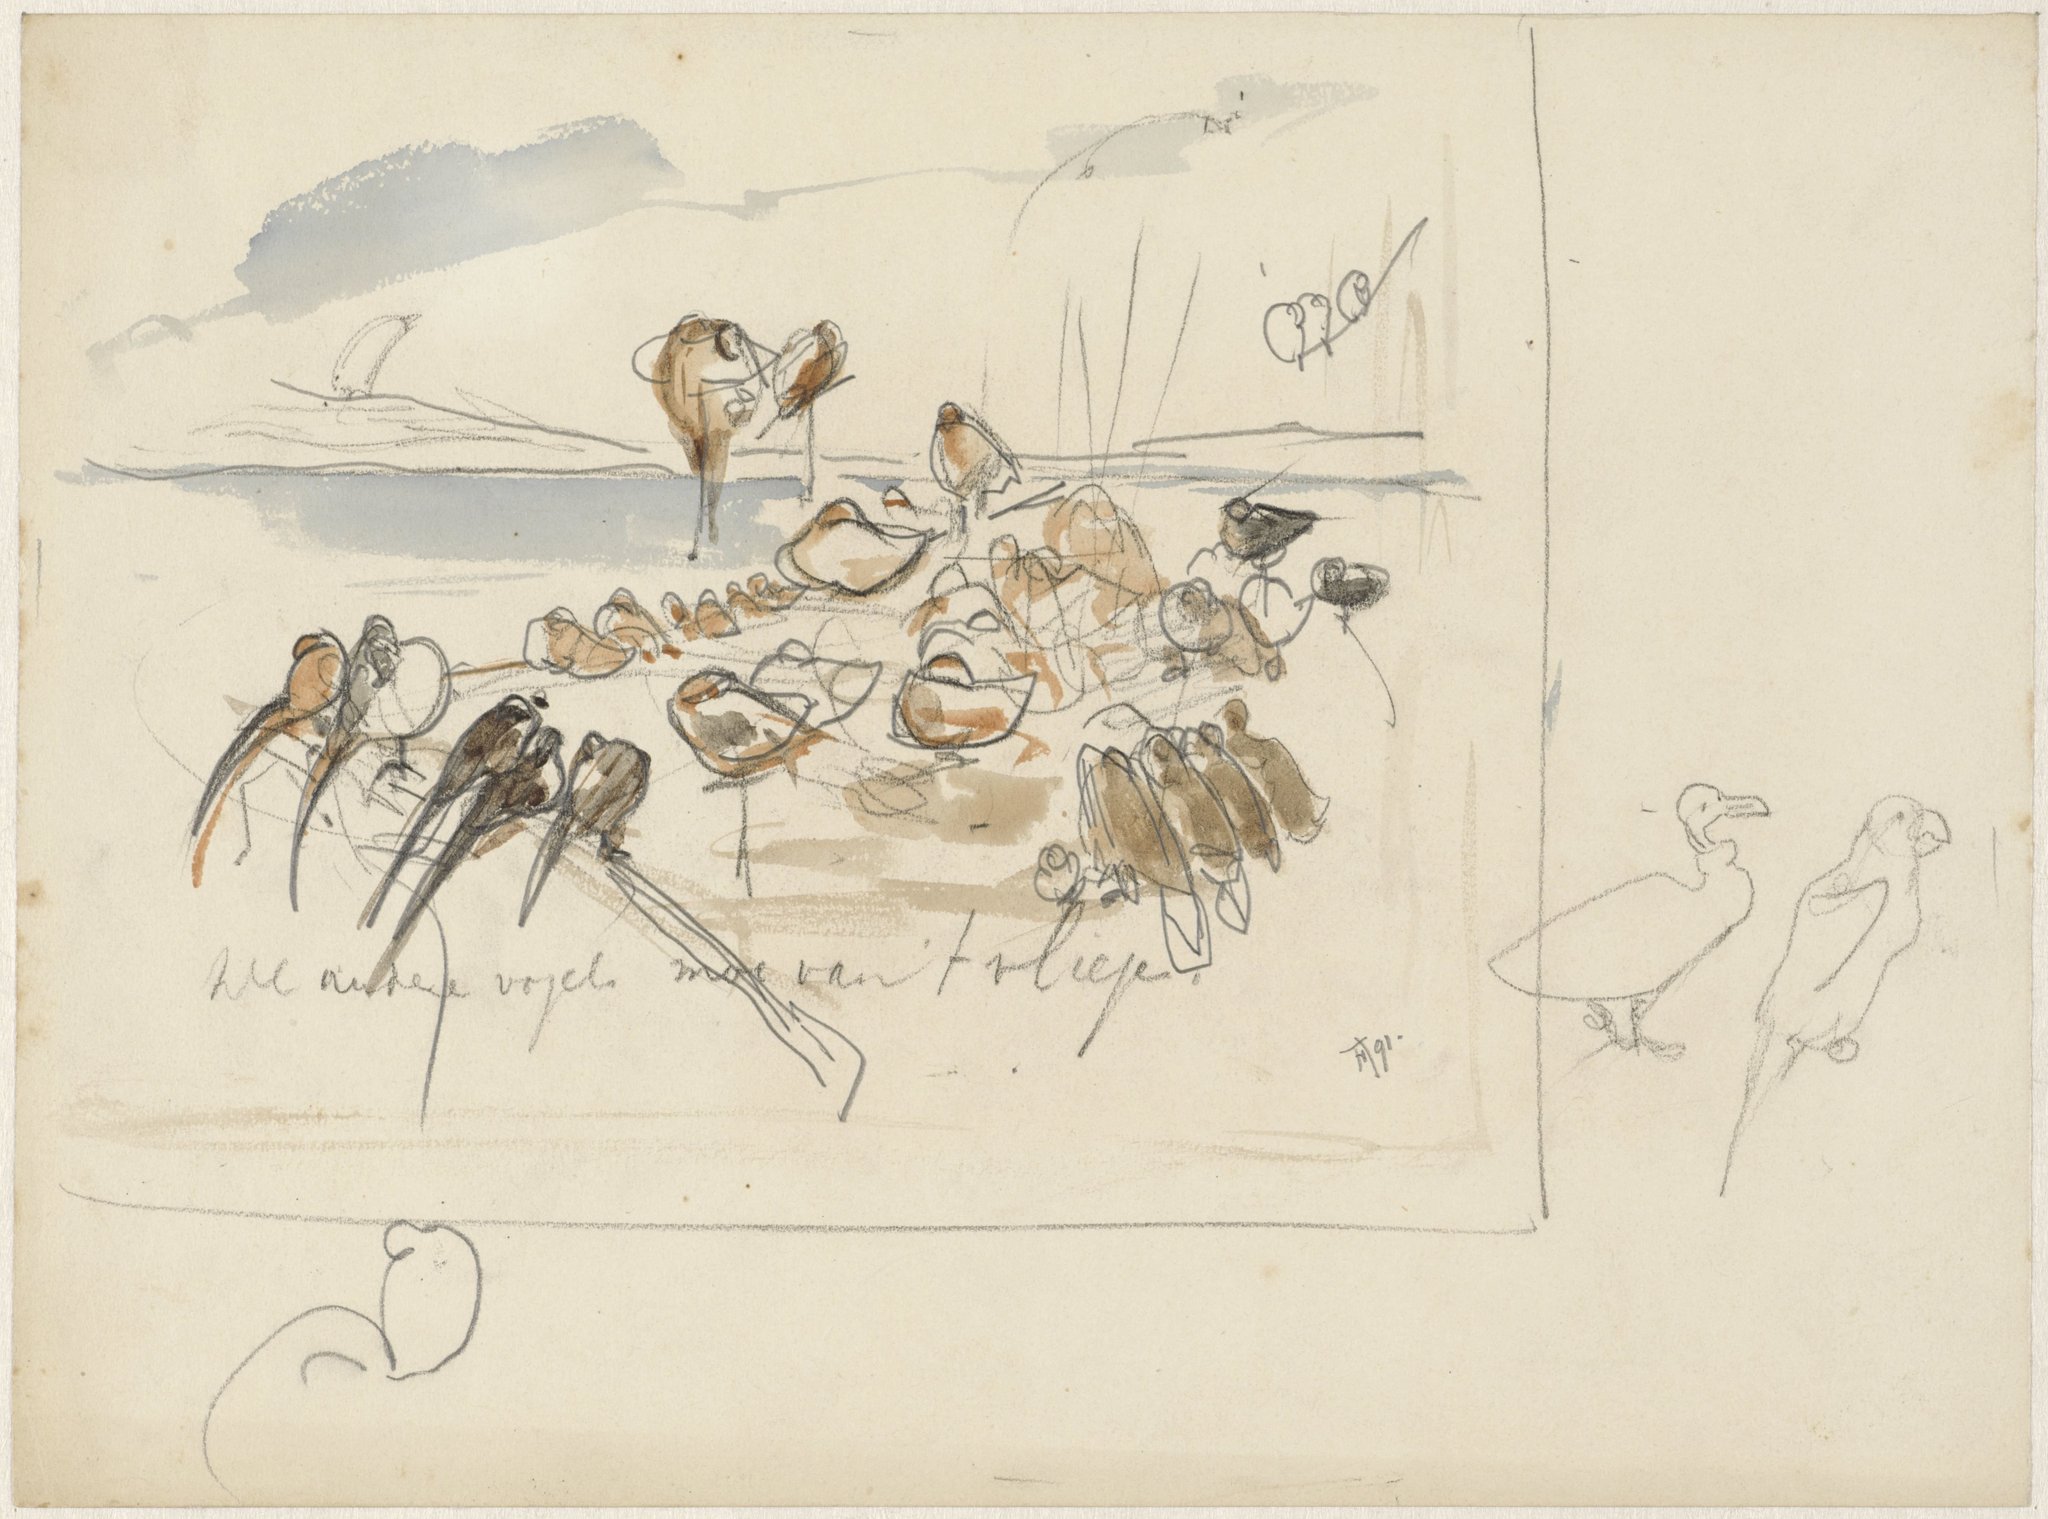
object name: drawing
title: Schets voor illustratie in Hoe de vogels aan een koning kwamen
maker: theo van hoytema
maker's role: draughtsman, painter, print maker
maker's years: 1863-1917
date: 1891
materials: chalk, paper, pencil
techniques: brush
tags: birds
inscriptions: date: ‘91’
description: Voorstudie voor prent in 'Hoe de vogels aan een koning kwamen'.